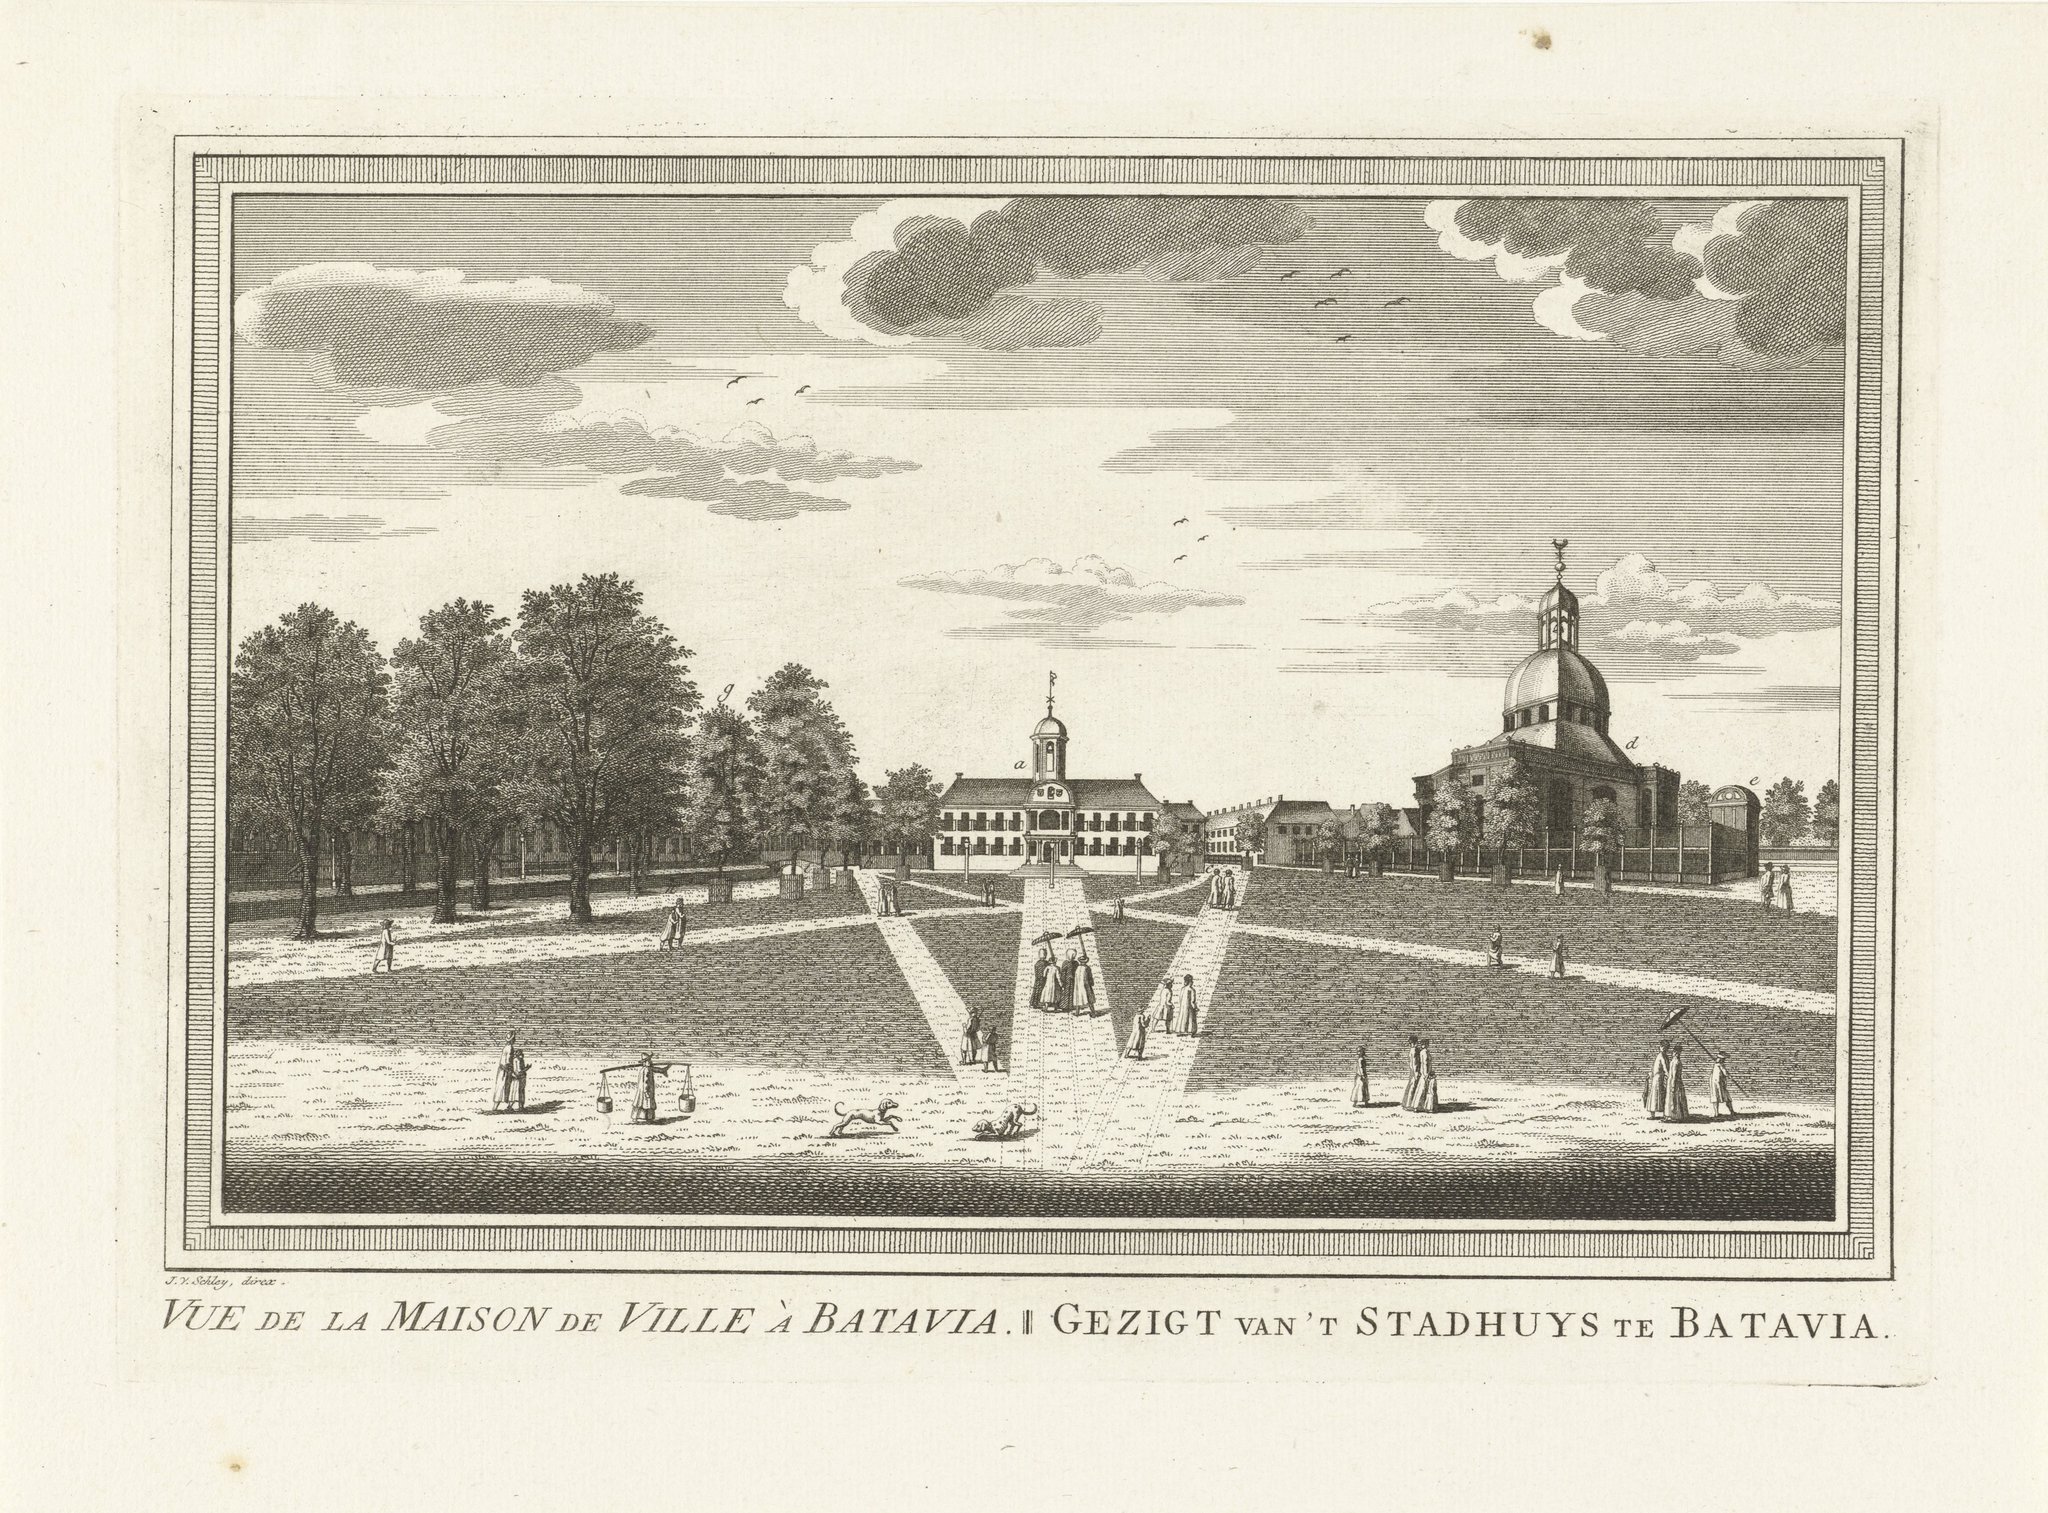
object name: book illustration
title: Vue de la Maison de Ville à Batavia. / Gezigt van 't Stadshuys te Batavia.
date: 1747-1779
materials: paper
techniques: engraving, etching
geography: amsterdam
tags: dog, batavia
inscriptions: collector's mark: Lugt 2228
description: Illustratie in: Bois, J.P.J. du: Histoire Générale Des Voyages, Ou Nouvelle Collection De Toutes Les Relations De Voyages Par Mer Et Par Terre, deel XVII, Den Haag: Pierre de Hondt, 1747- 1779, na p. 264.